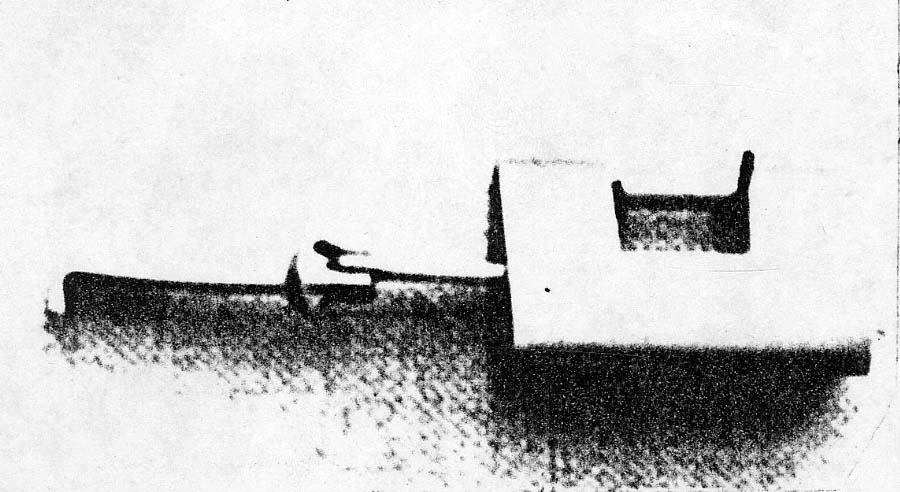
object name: padlock with key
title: Padlock and Key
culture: indian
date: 1701-1800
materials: bronze